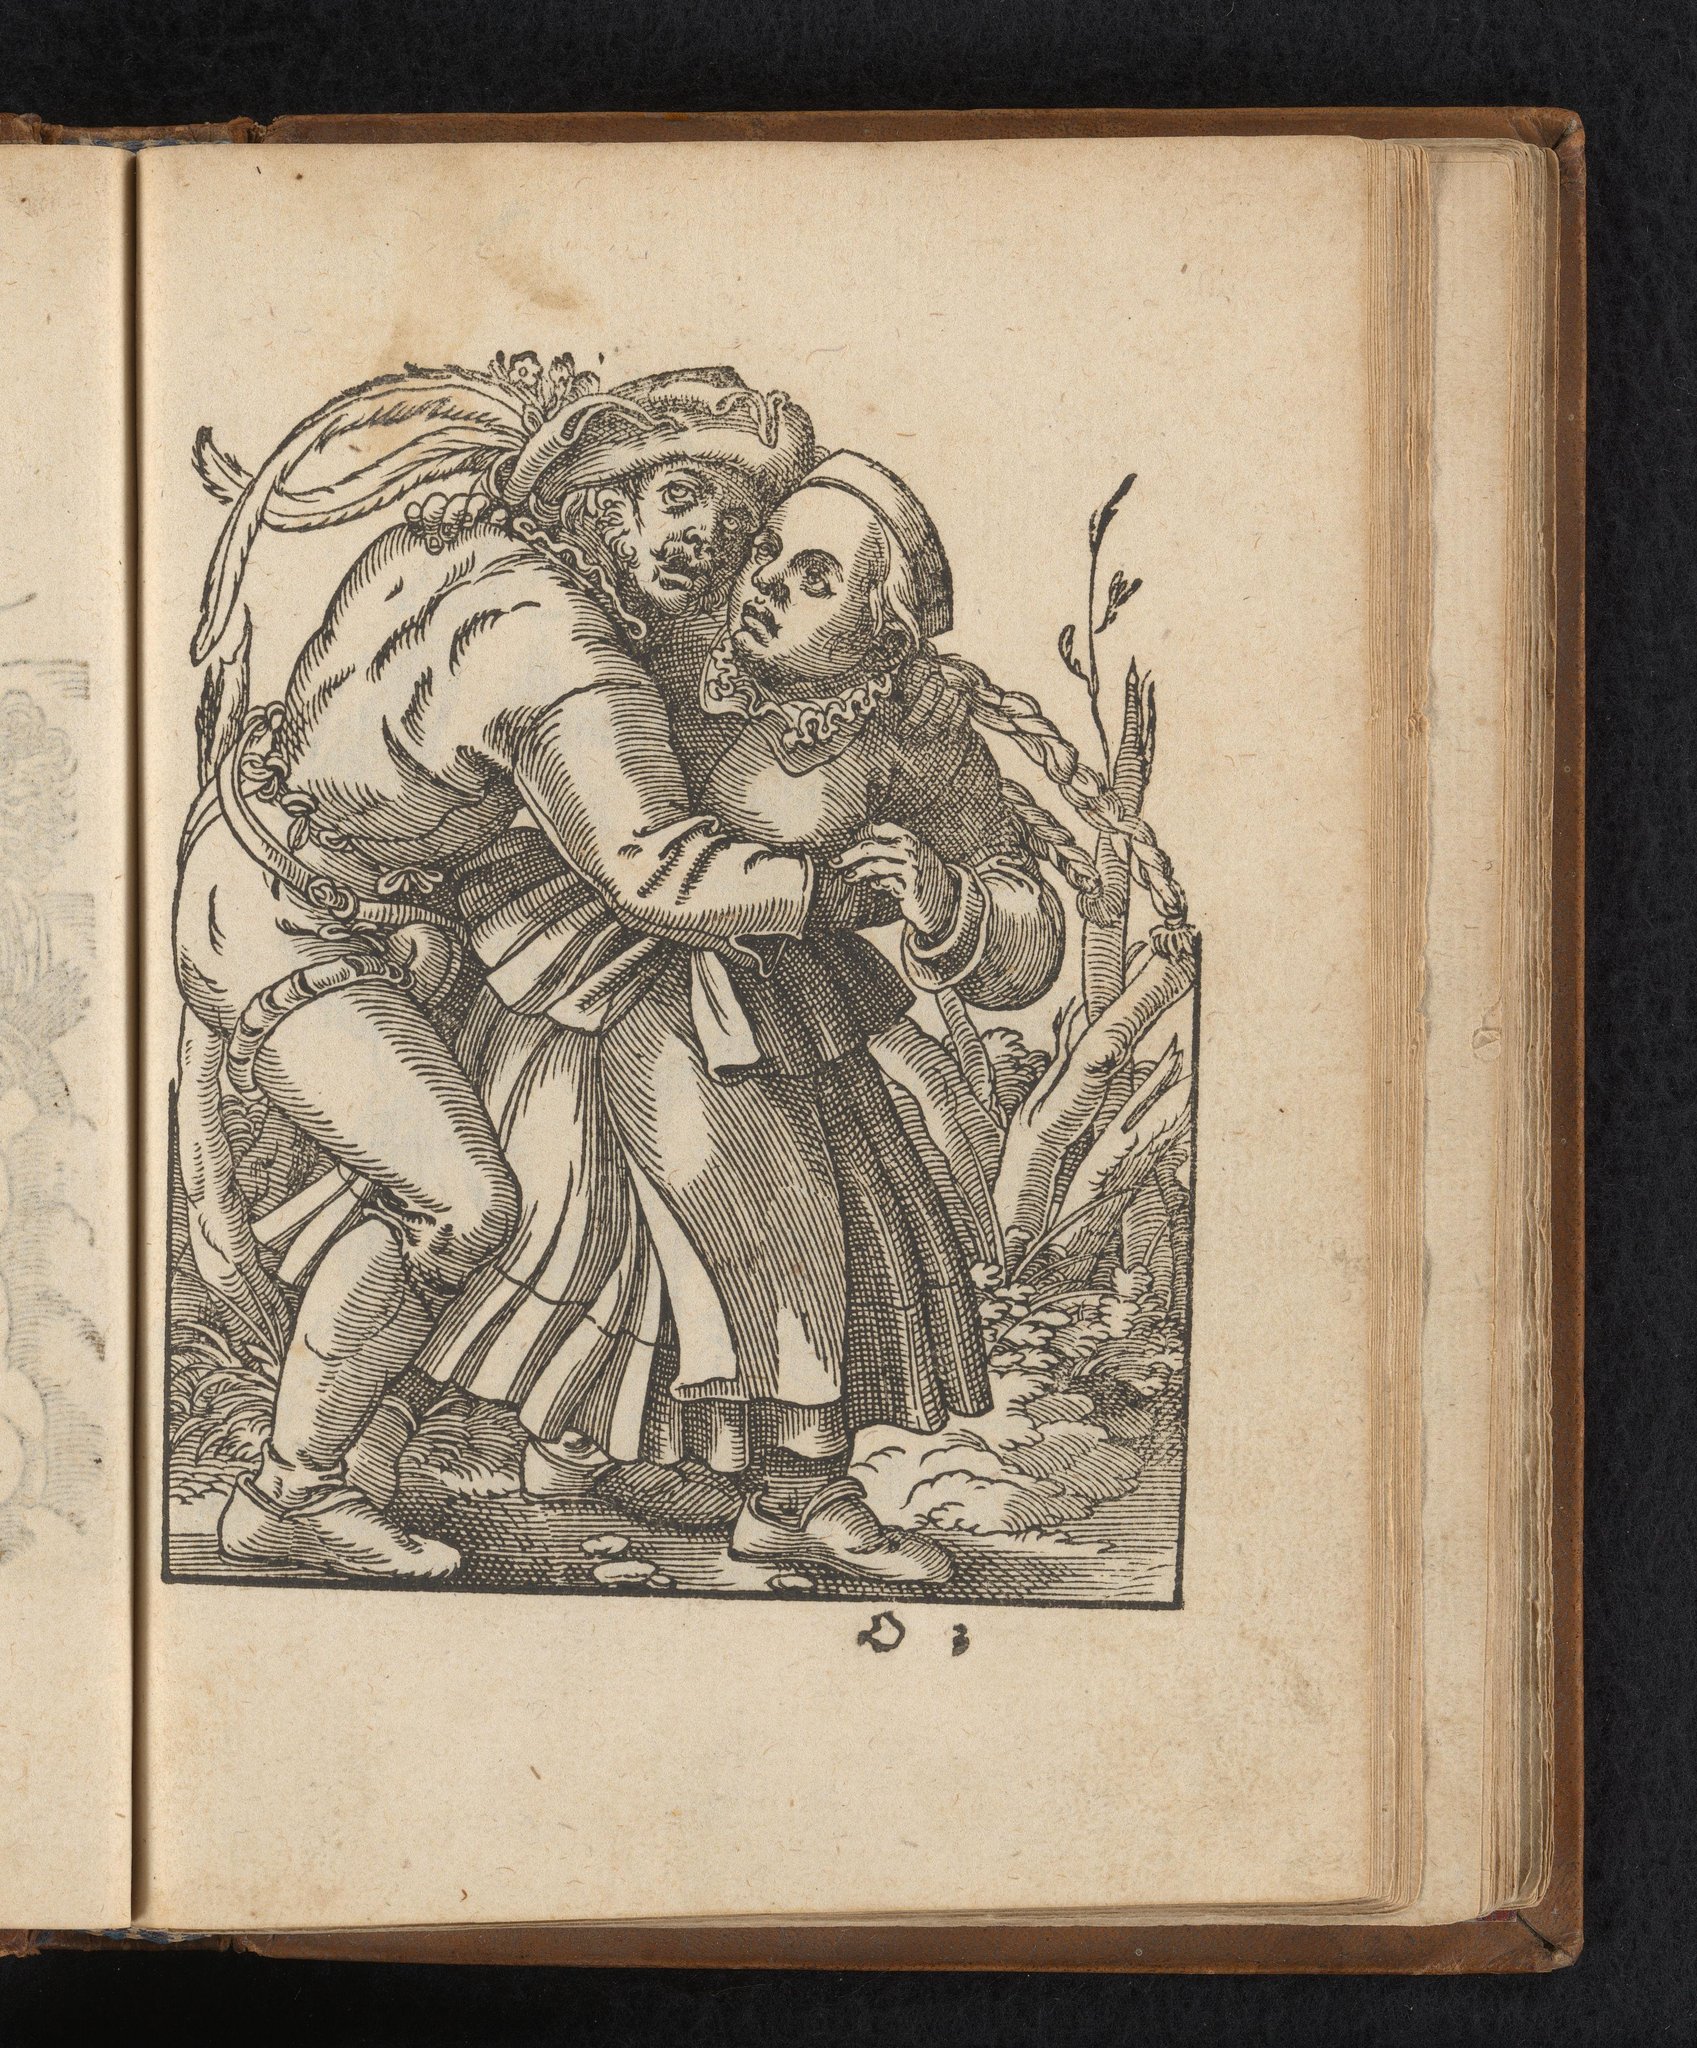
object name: print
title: Omhelzende boer en boerin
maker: Anonymous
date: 1578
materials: paper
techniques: woodcut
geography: nuremberg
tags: embracing each other, kissing, farmers, farmers - aa - female farmer, farmer's wife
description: Omhelzende boerenpaar. Onderdeel van het modelboek Enchiridion artis pingendi, fingendi & sculpendi met 108 figuren bedoeld voor beginnende schilders, beeldhouwers en prentmakers.